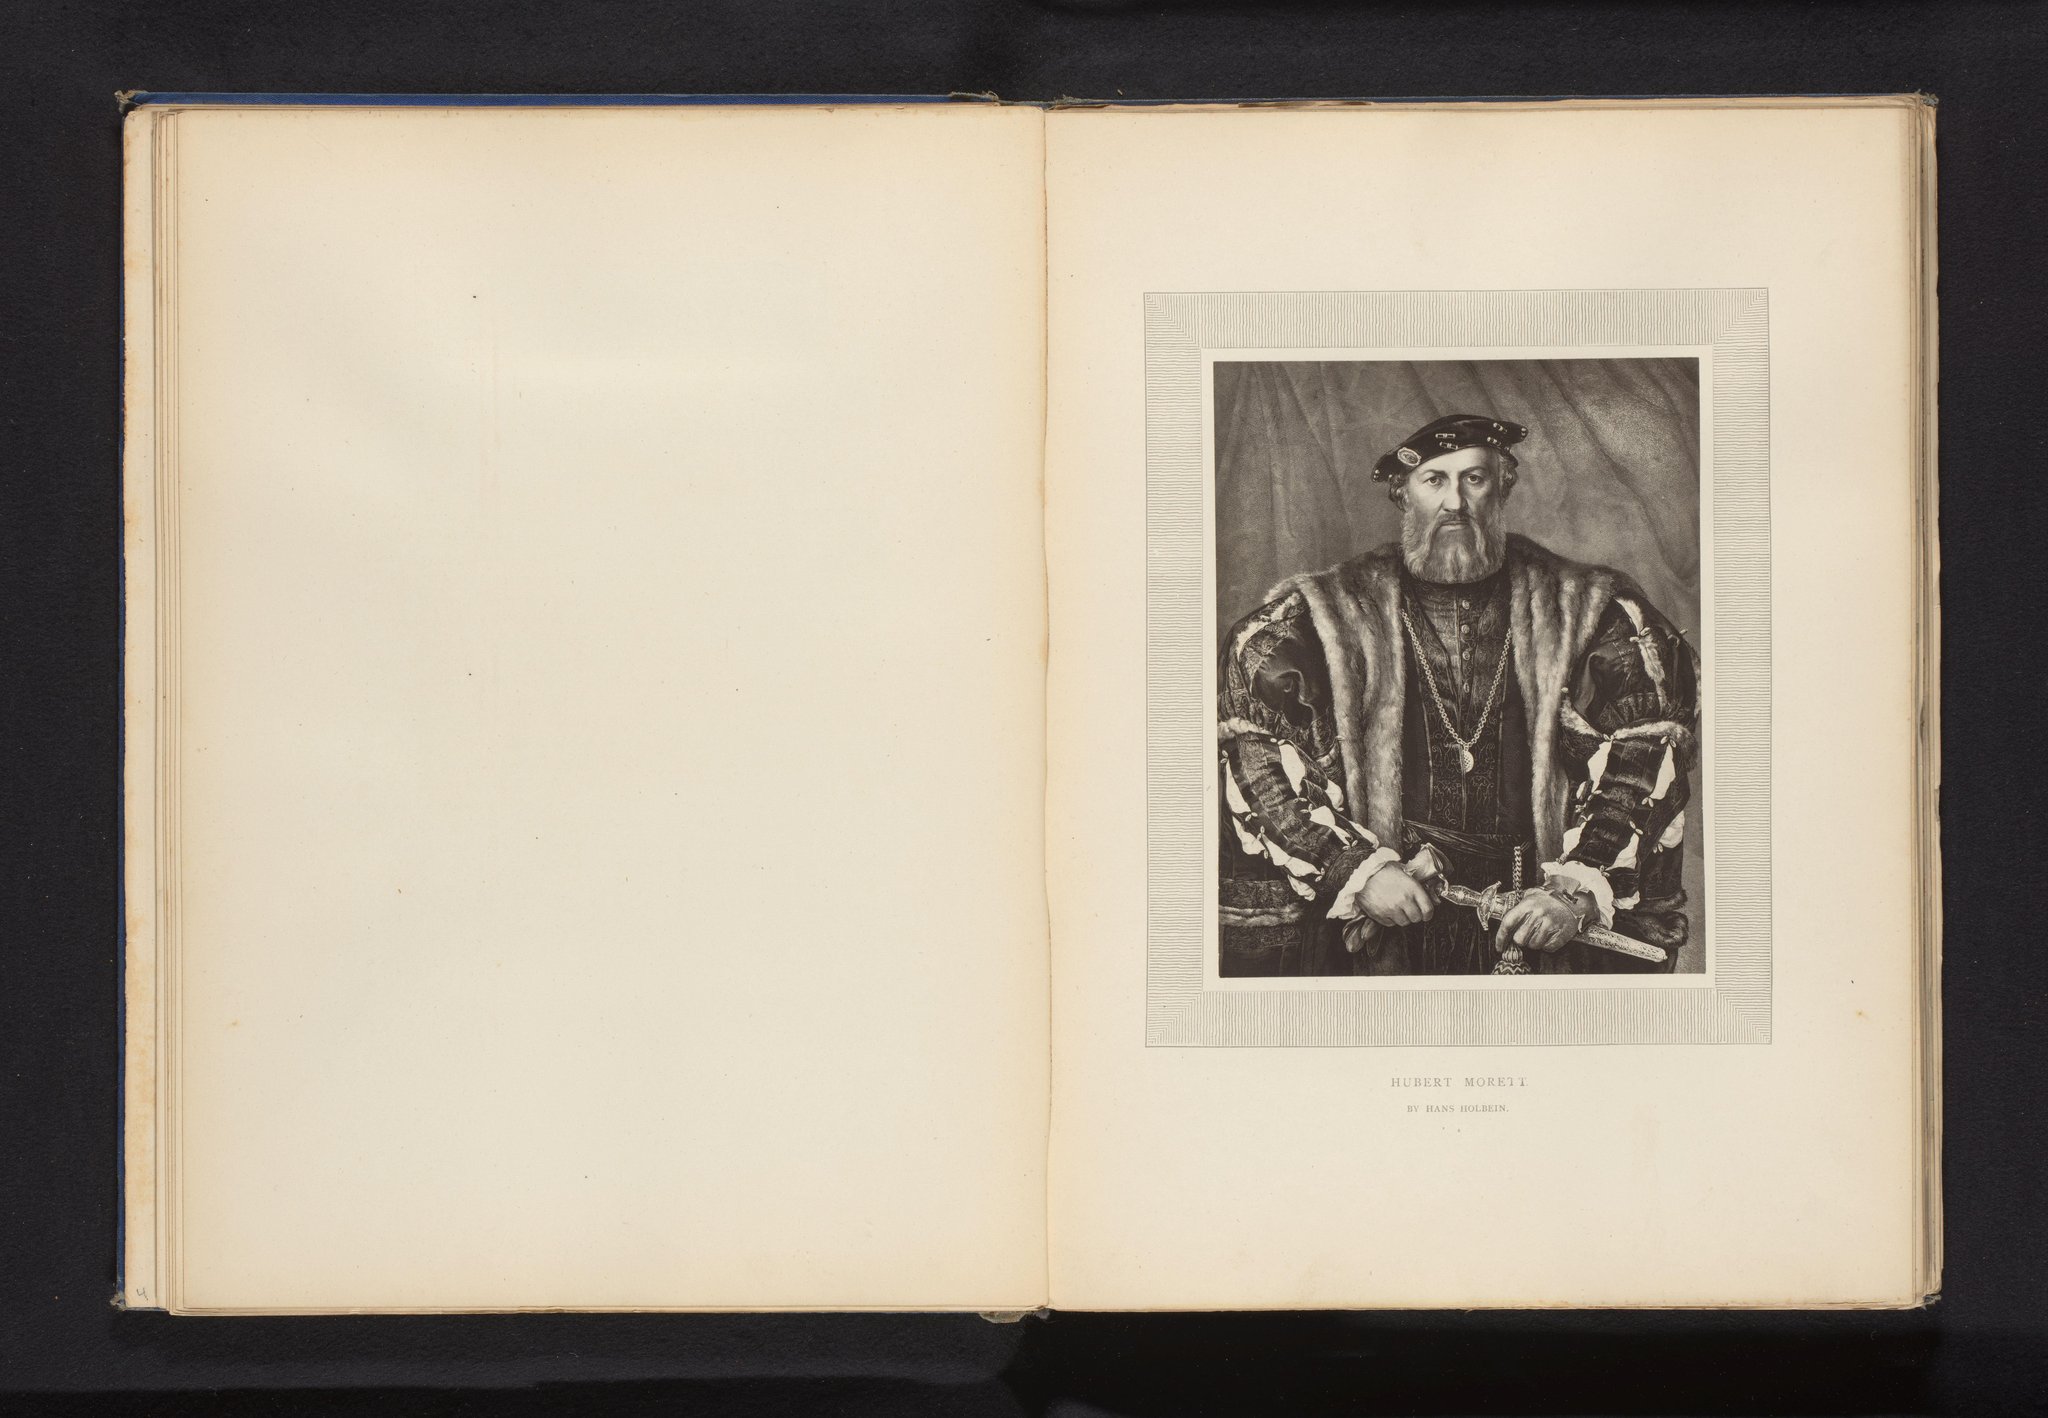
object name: photomechanical print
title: Reproductie van een prent van een geschilderd portret van Hubert Morett naar Hans Holbein II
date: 1870-1875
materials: paper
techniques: woodburytype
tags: historical persons